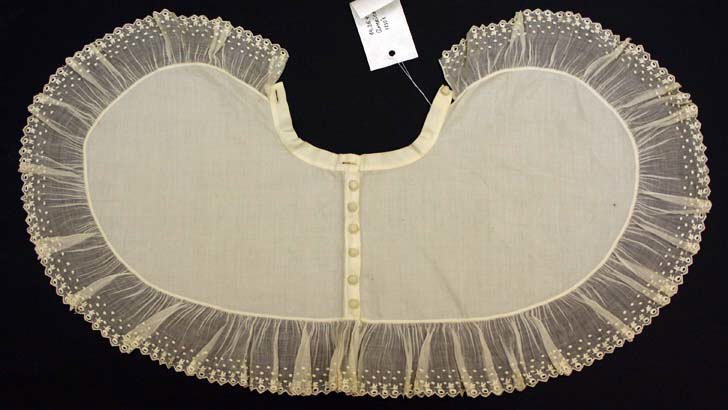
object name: collar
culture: american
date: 1830-1839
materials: cotton